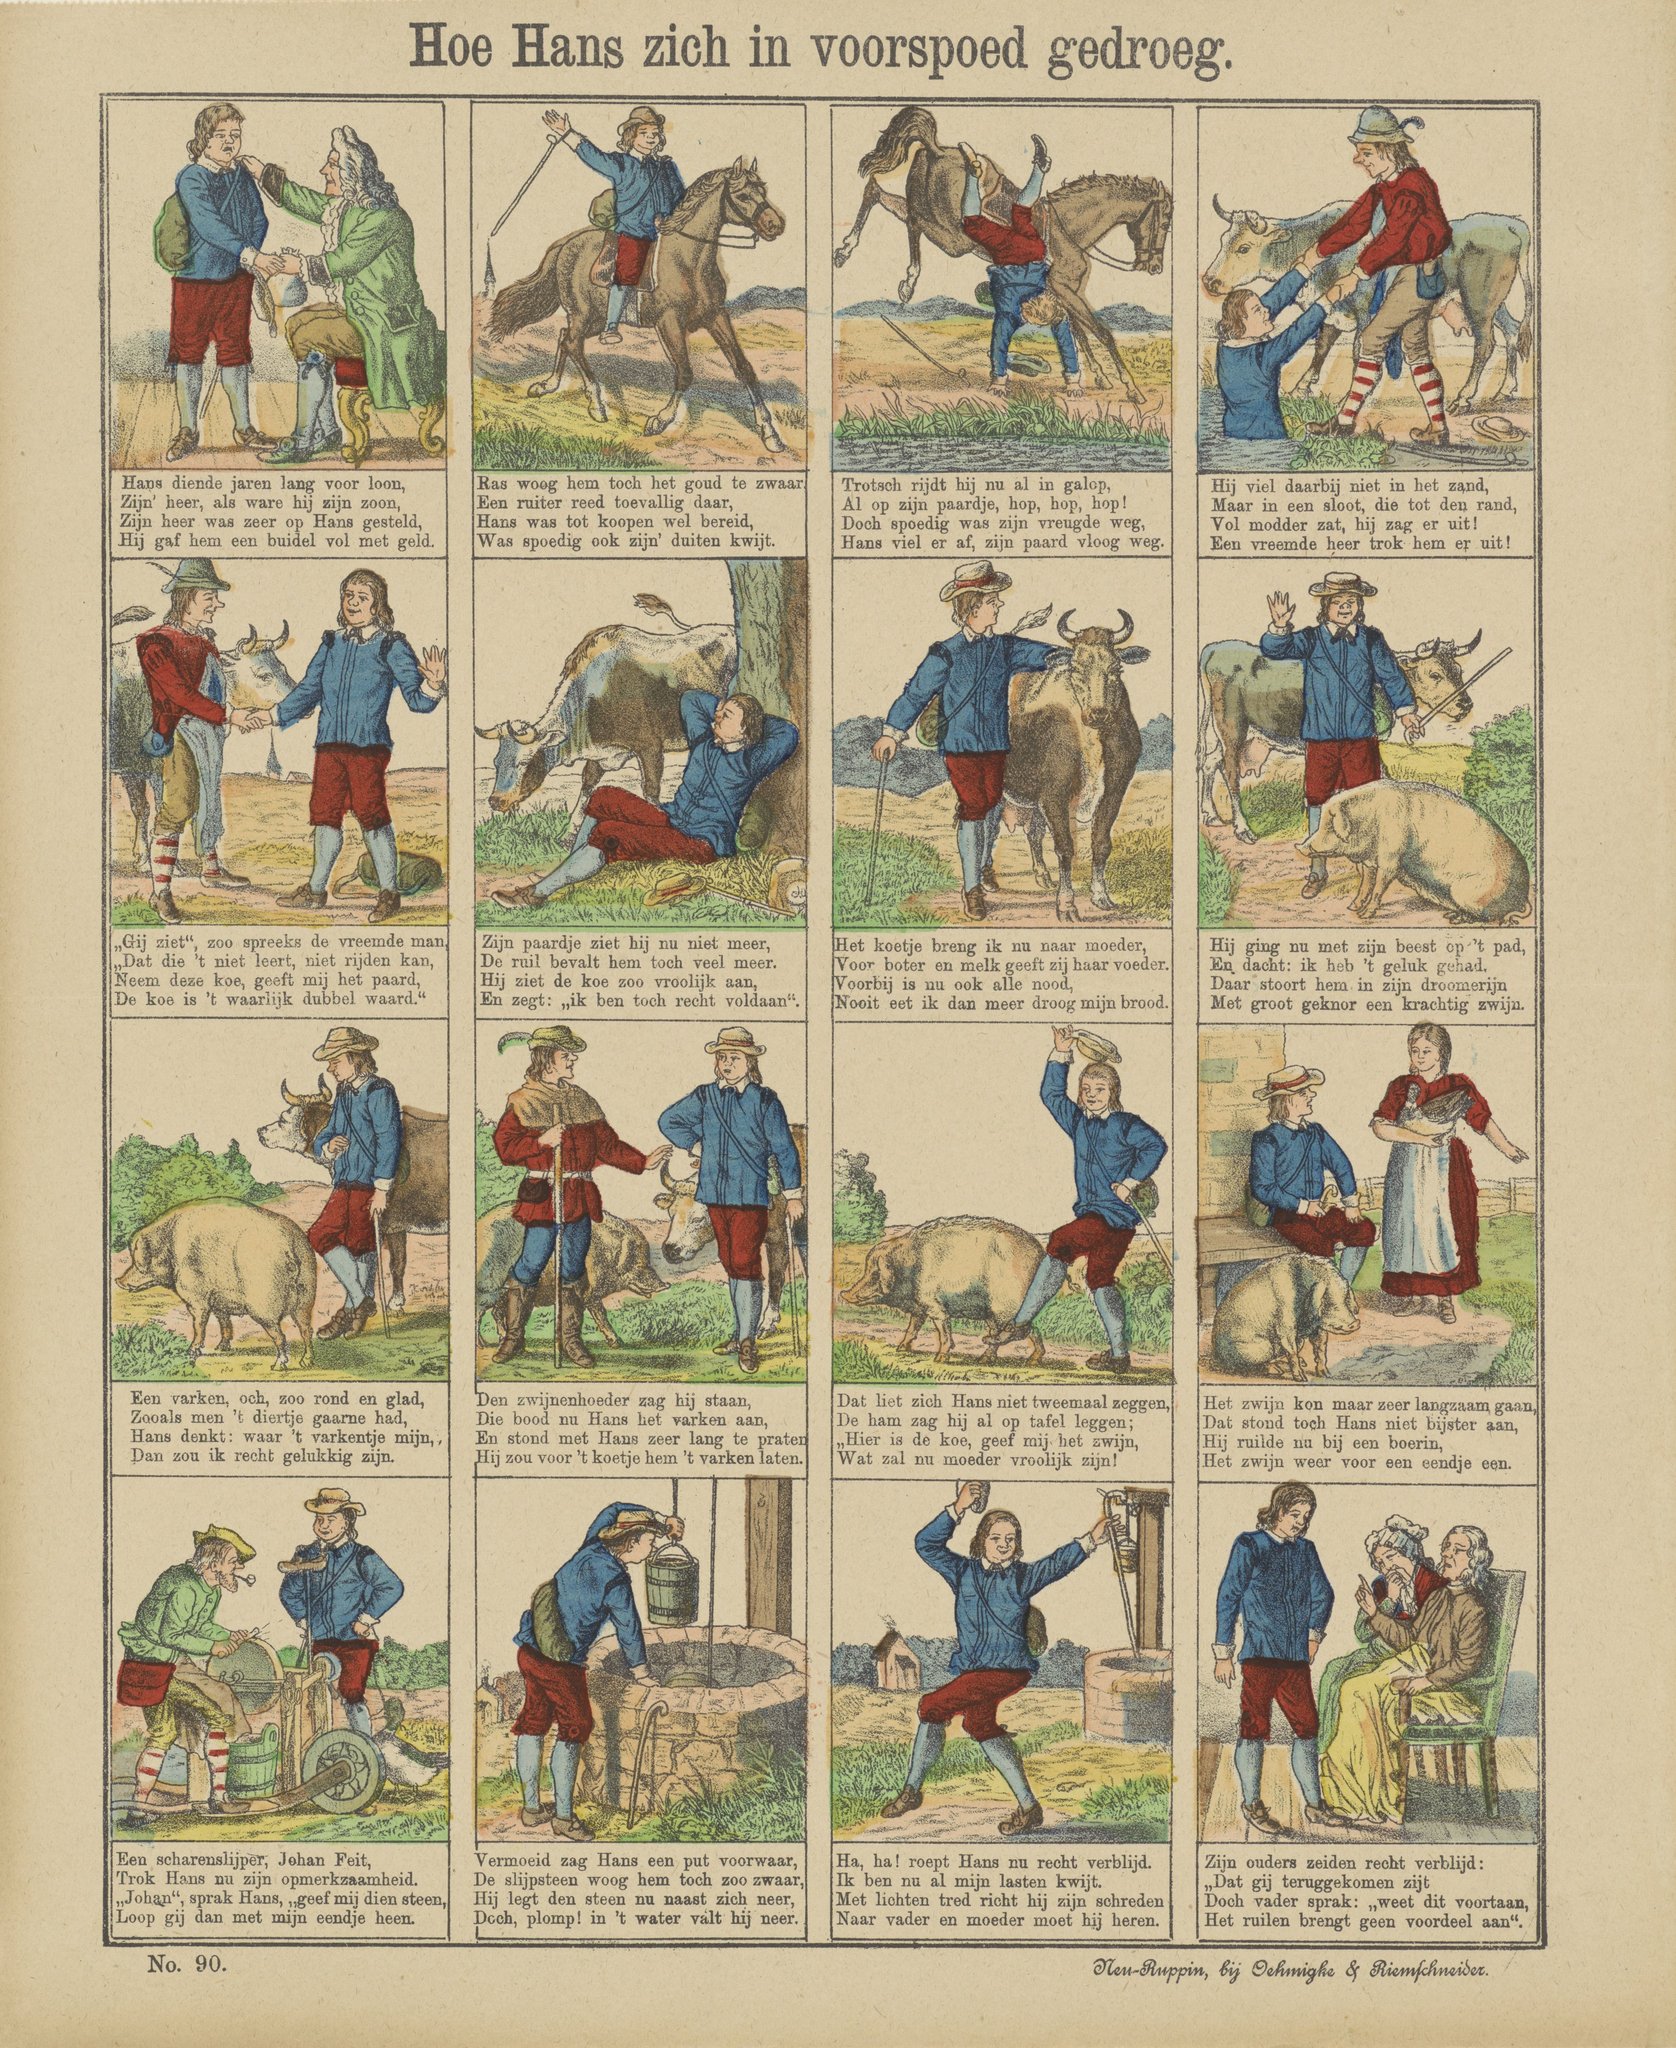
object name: popular print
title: Hoe Hans zich in voorspoed gedroeg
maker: Anonymous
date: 1828-1937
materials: paper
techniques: hand coloring, letterpress printing, lithograph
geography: neuruppin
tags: tales and fairy tales, trade, commerce and finance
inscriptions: collector's mark: Lugt 2760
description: Blad met 16 voorstellingen uit het leven van de jongen genaamd Hans, die zijn geld inwisselde voor een paard, het paard voor een koe, de koe voor een zwijn, het zwijn voor een eend en zijn eend voor een slijpsteen. Onder elke afbeelding een onderschrift. Genummerd linksonder: No. 90.